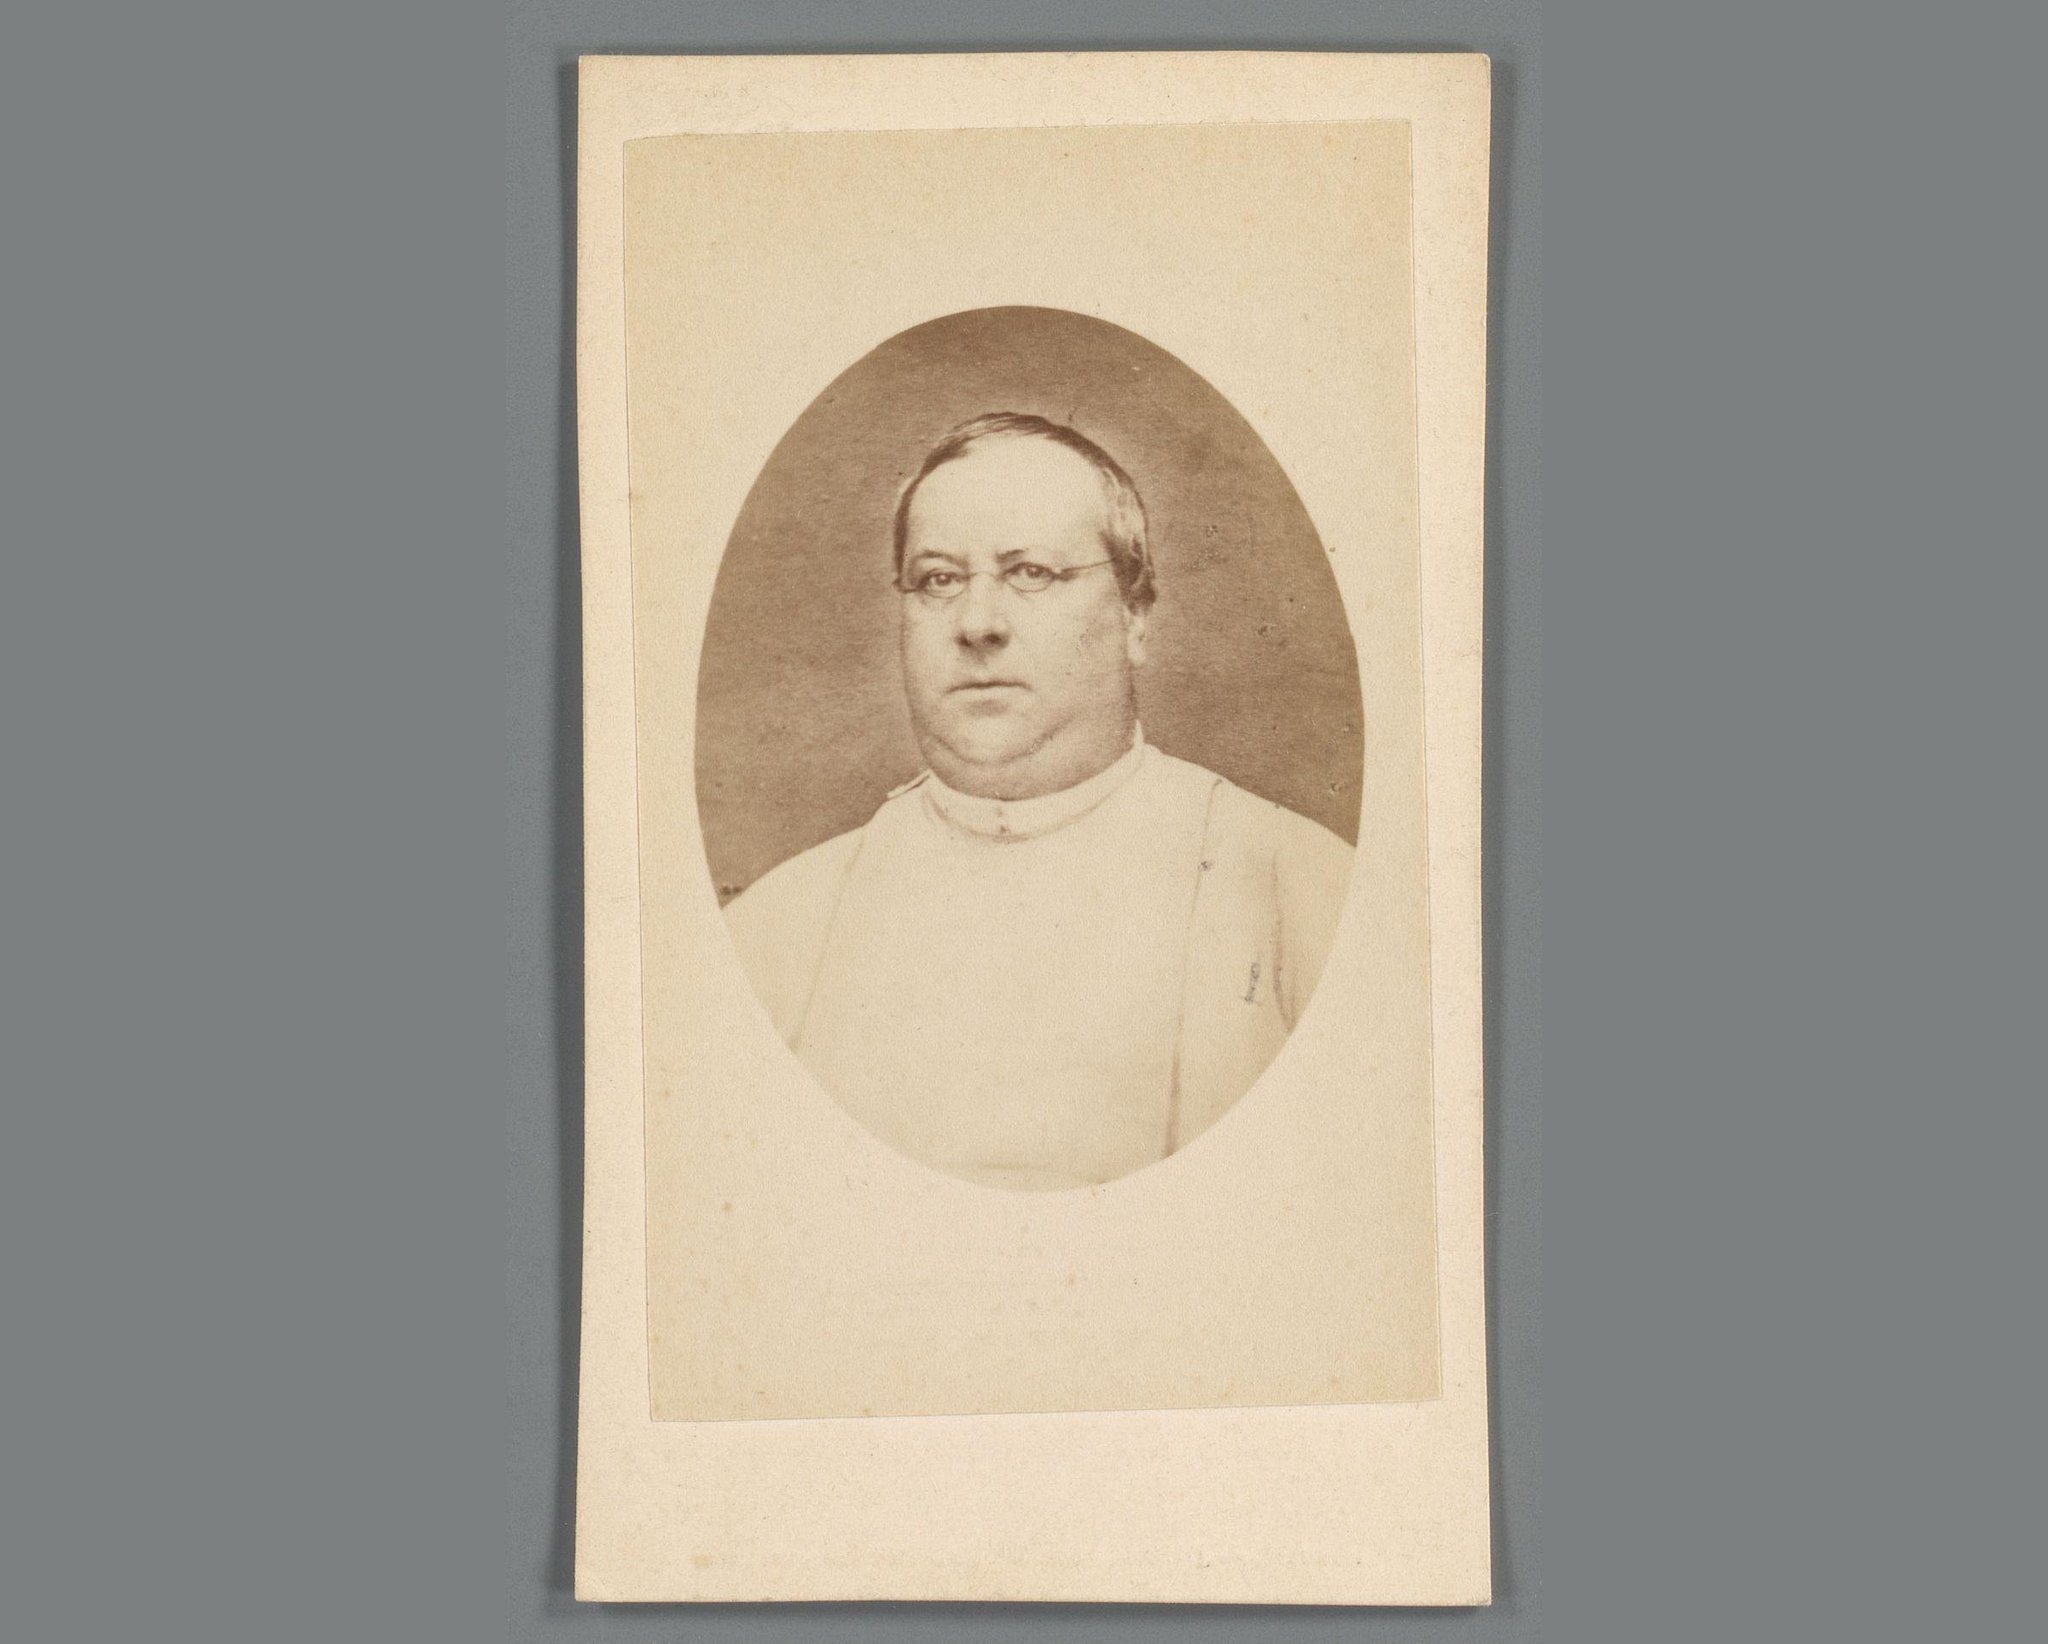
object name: photograph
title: Portret van Bernardus Joostens op bidprent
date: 1876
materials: cardboard, paper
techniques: albumen print, letterpress printing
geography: oorbeek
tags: priest (roman catholic), historical persons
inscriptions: inscription: ‘Jesus, Maria, Norbertus (...) Brussel. - Drukk. van We. Ch. Vanderauwera.’